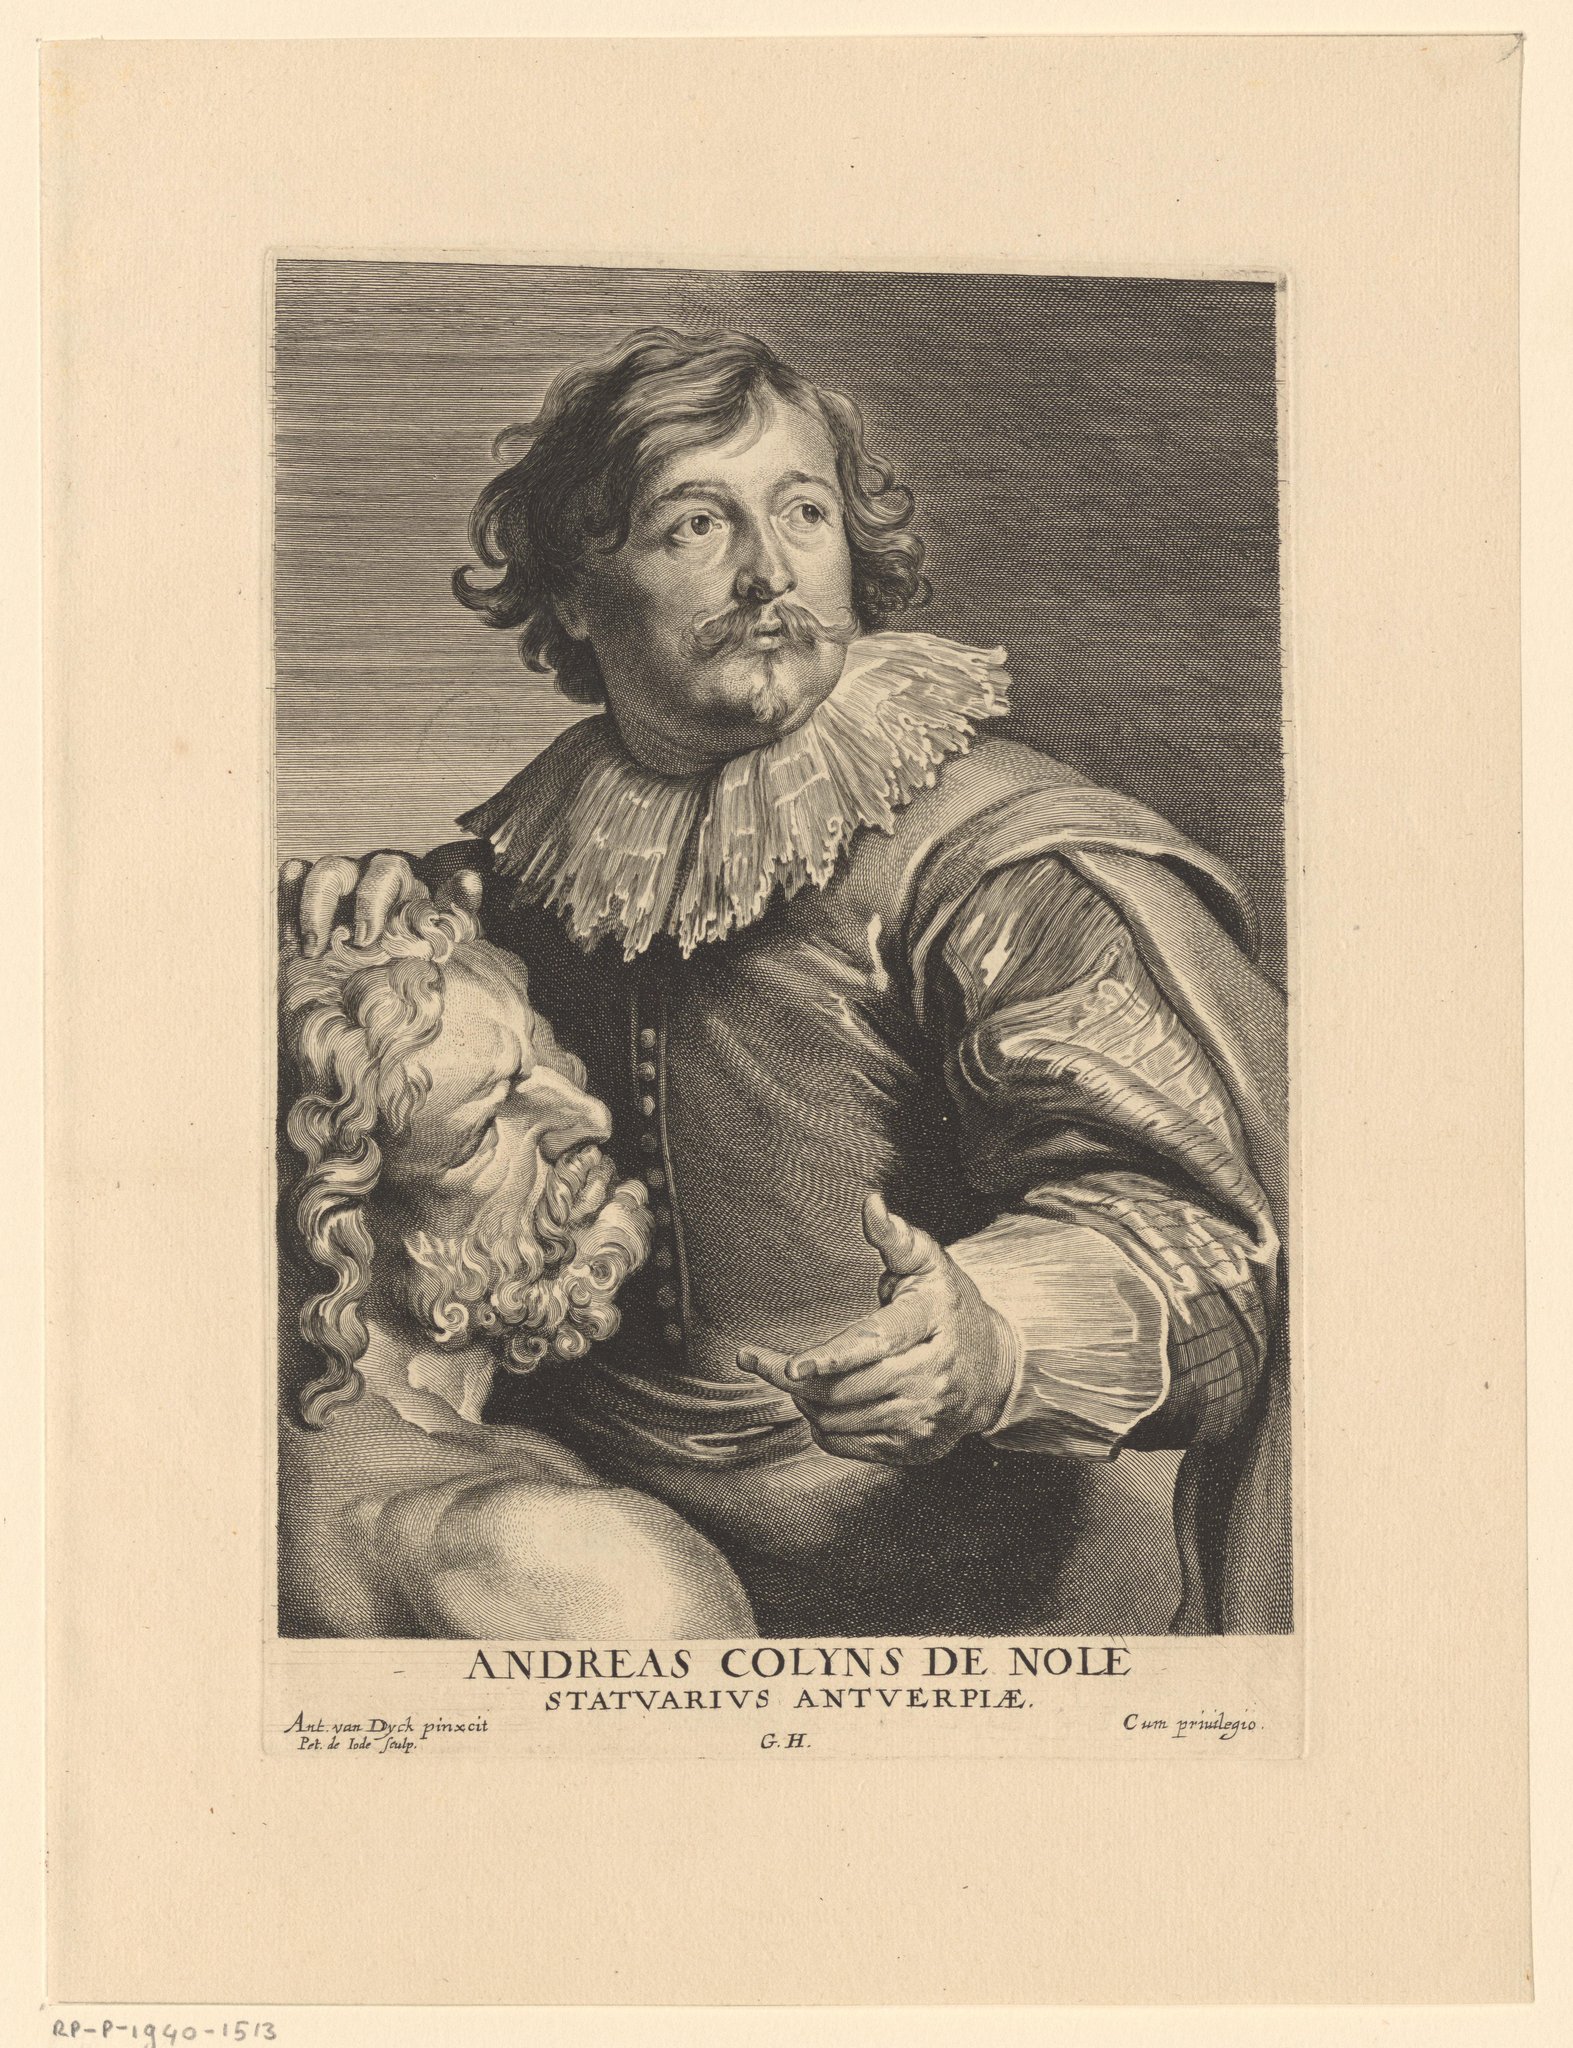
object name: print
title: Portret van Andreas de Nole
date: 1626-1670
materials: paper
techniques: engraving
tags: antwerp, sculptor, andreas de nole, portrait, self-portrait of sculptor, historical persons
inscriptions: collector's mark: Lugt 2760, collector's mark: Lugt 2166, collector's mark: Lugt 2228